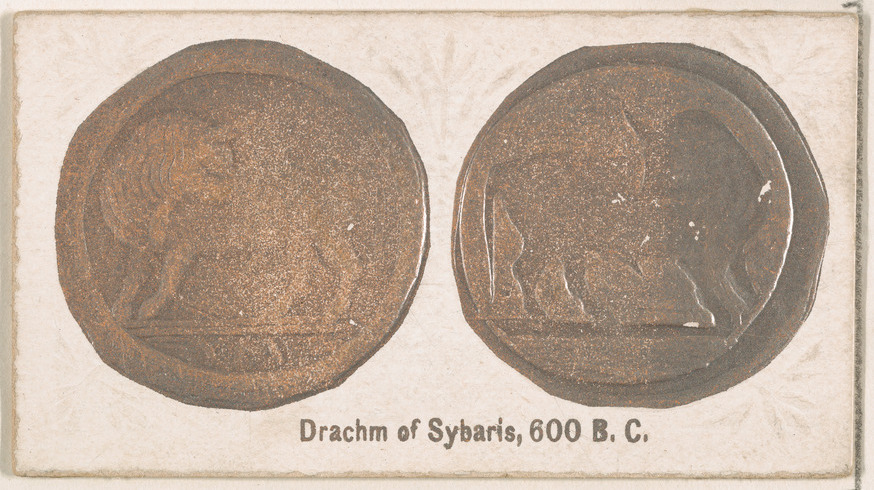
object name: print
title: Drachm of Sybaris, 600 B.C., from the Ancient Coins series (N180) issued by Wm. S. Kimball & Co.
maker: william s. kimball & company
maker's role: publisher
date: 1888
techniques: color lithograph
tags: coins